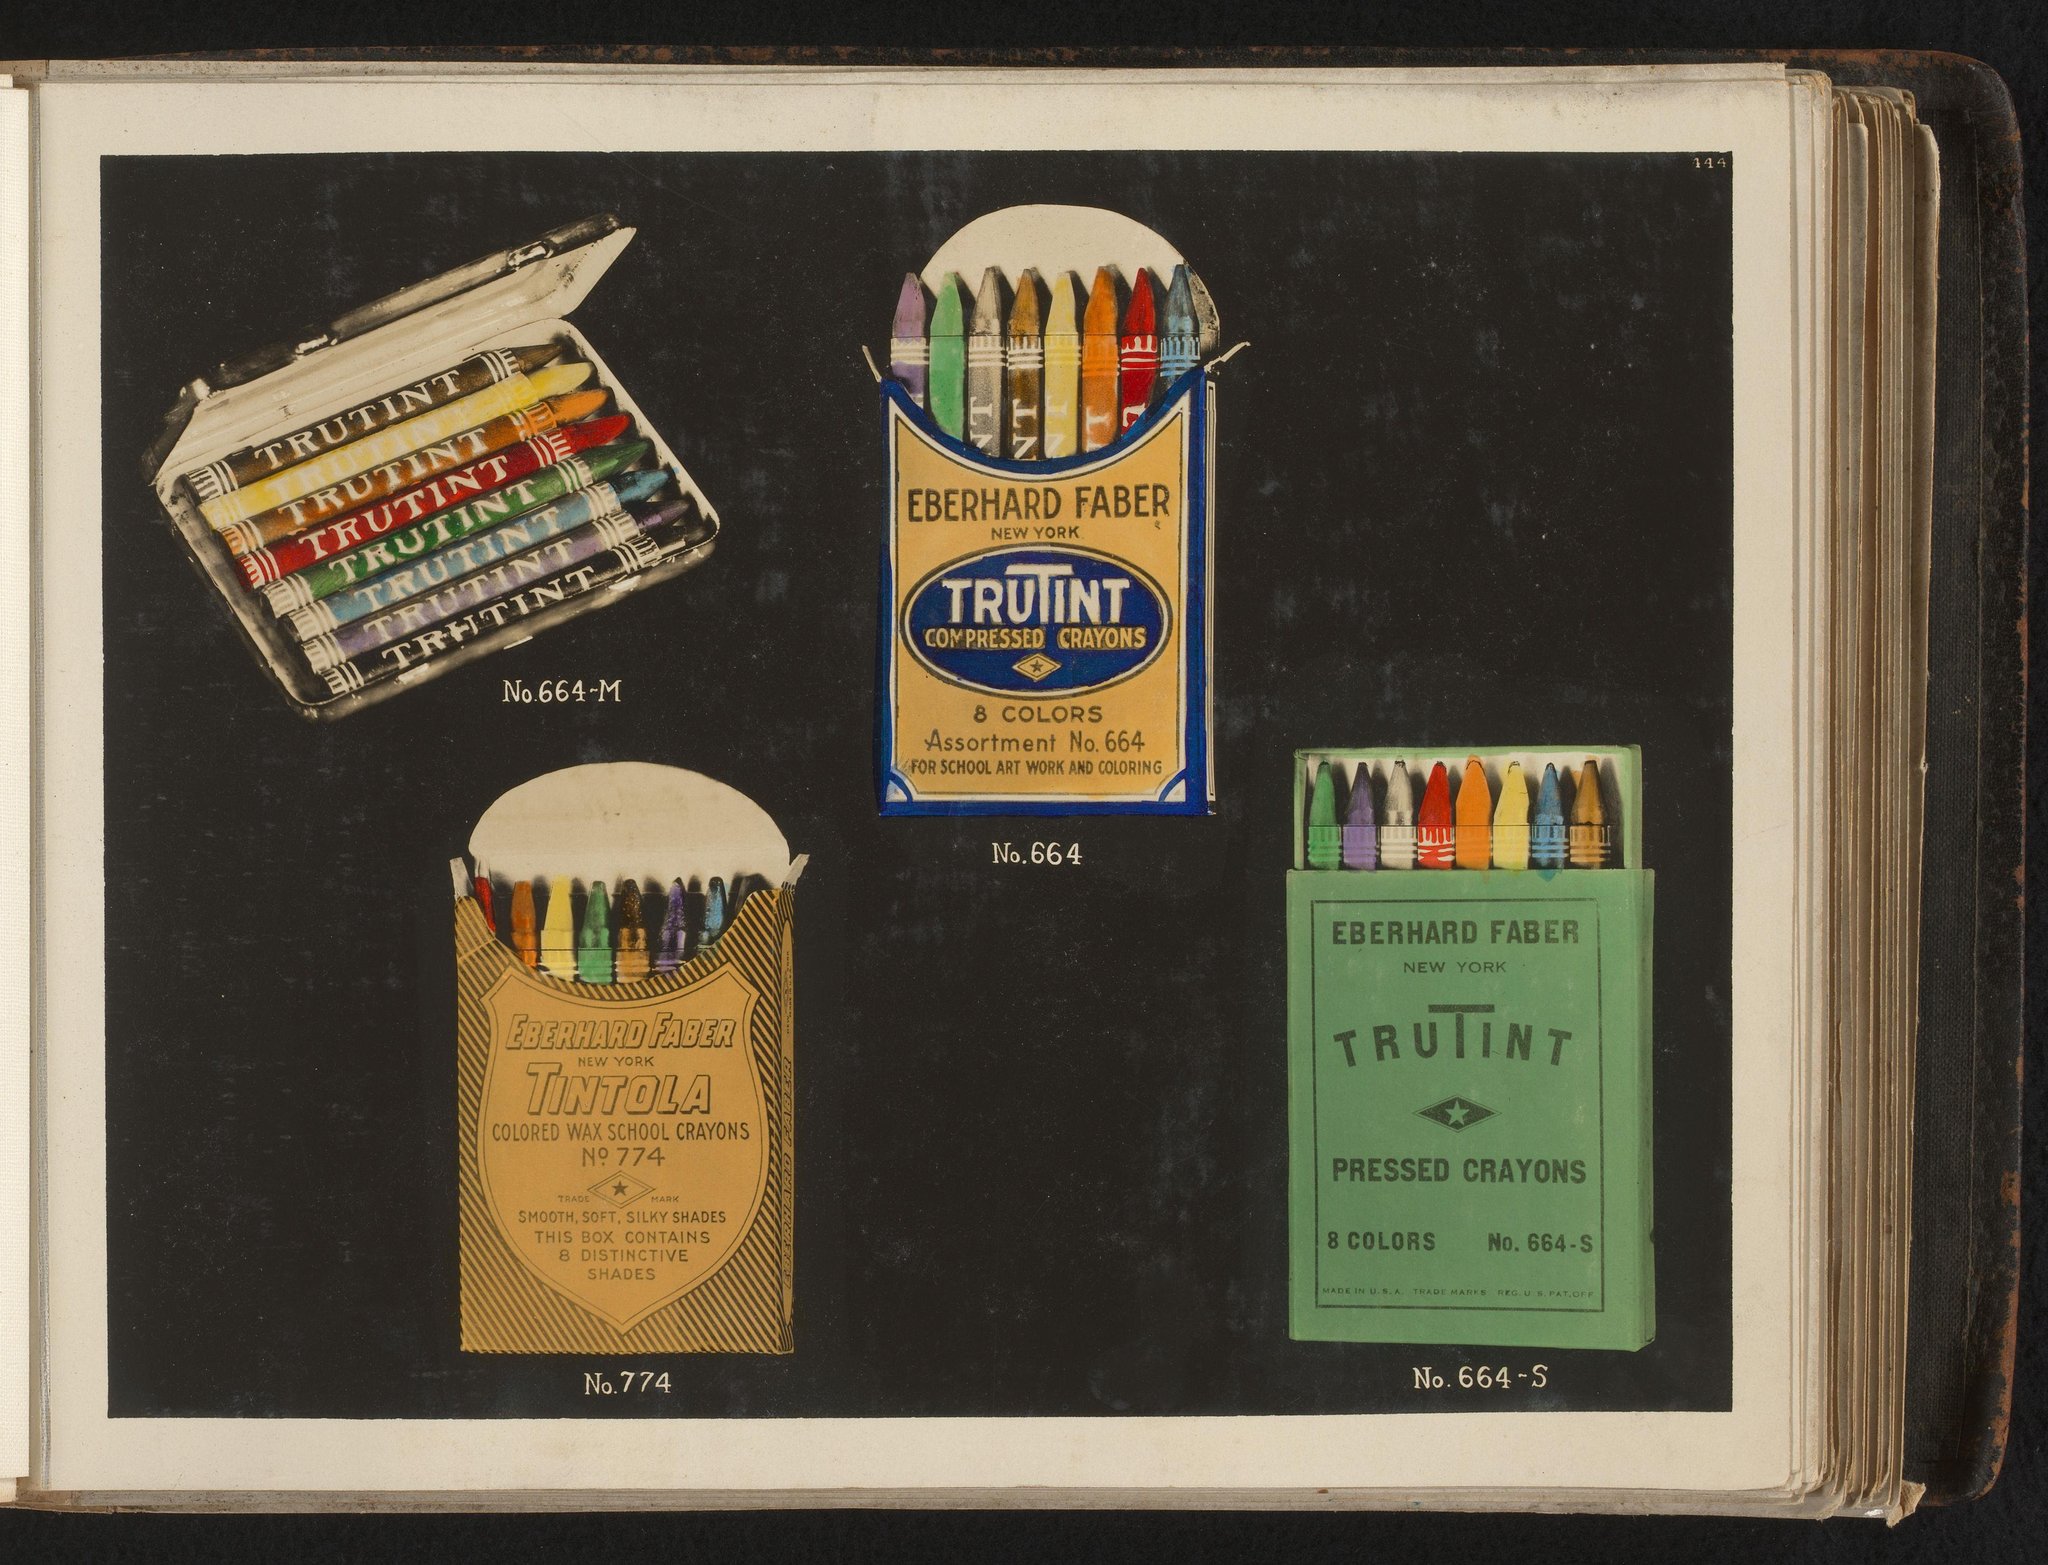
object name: photograph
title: Sets met krijt van Eberhard Faber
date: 1915-1935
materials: paper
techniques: gelatin silver print, hand coloring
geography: springfield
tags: writing tools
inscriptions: stamp: ‘Paramount/ Commercial Studios/ 145 Chestnut St./ Springfield - Mass.’, number: ‘444’